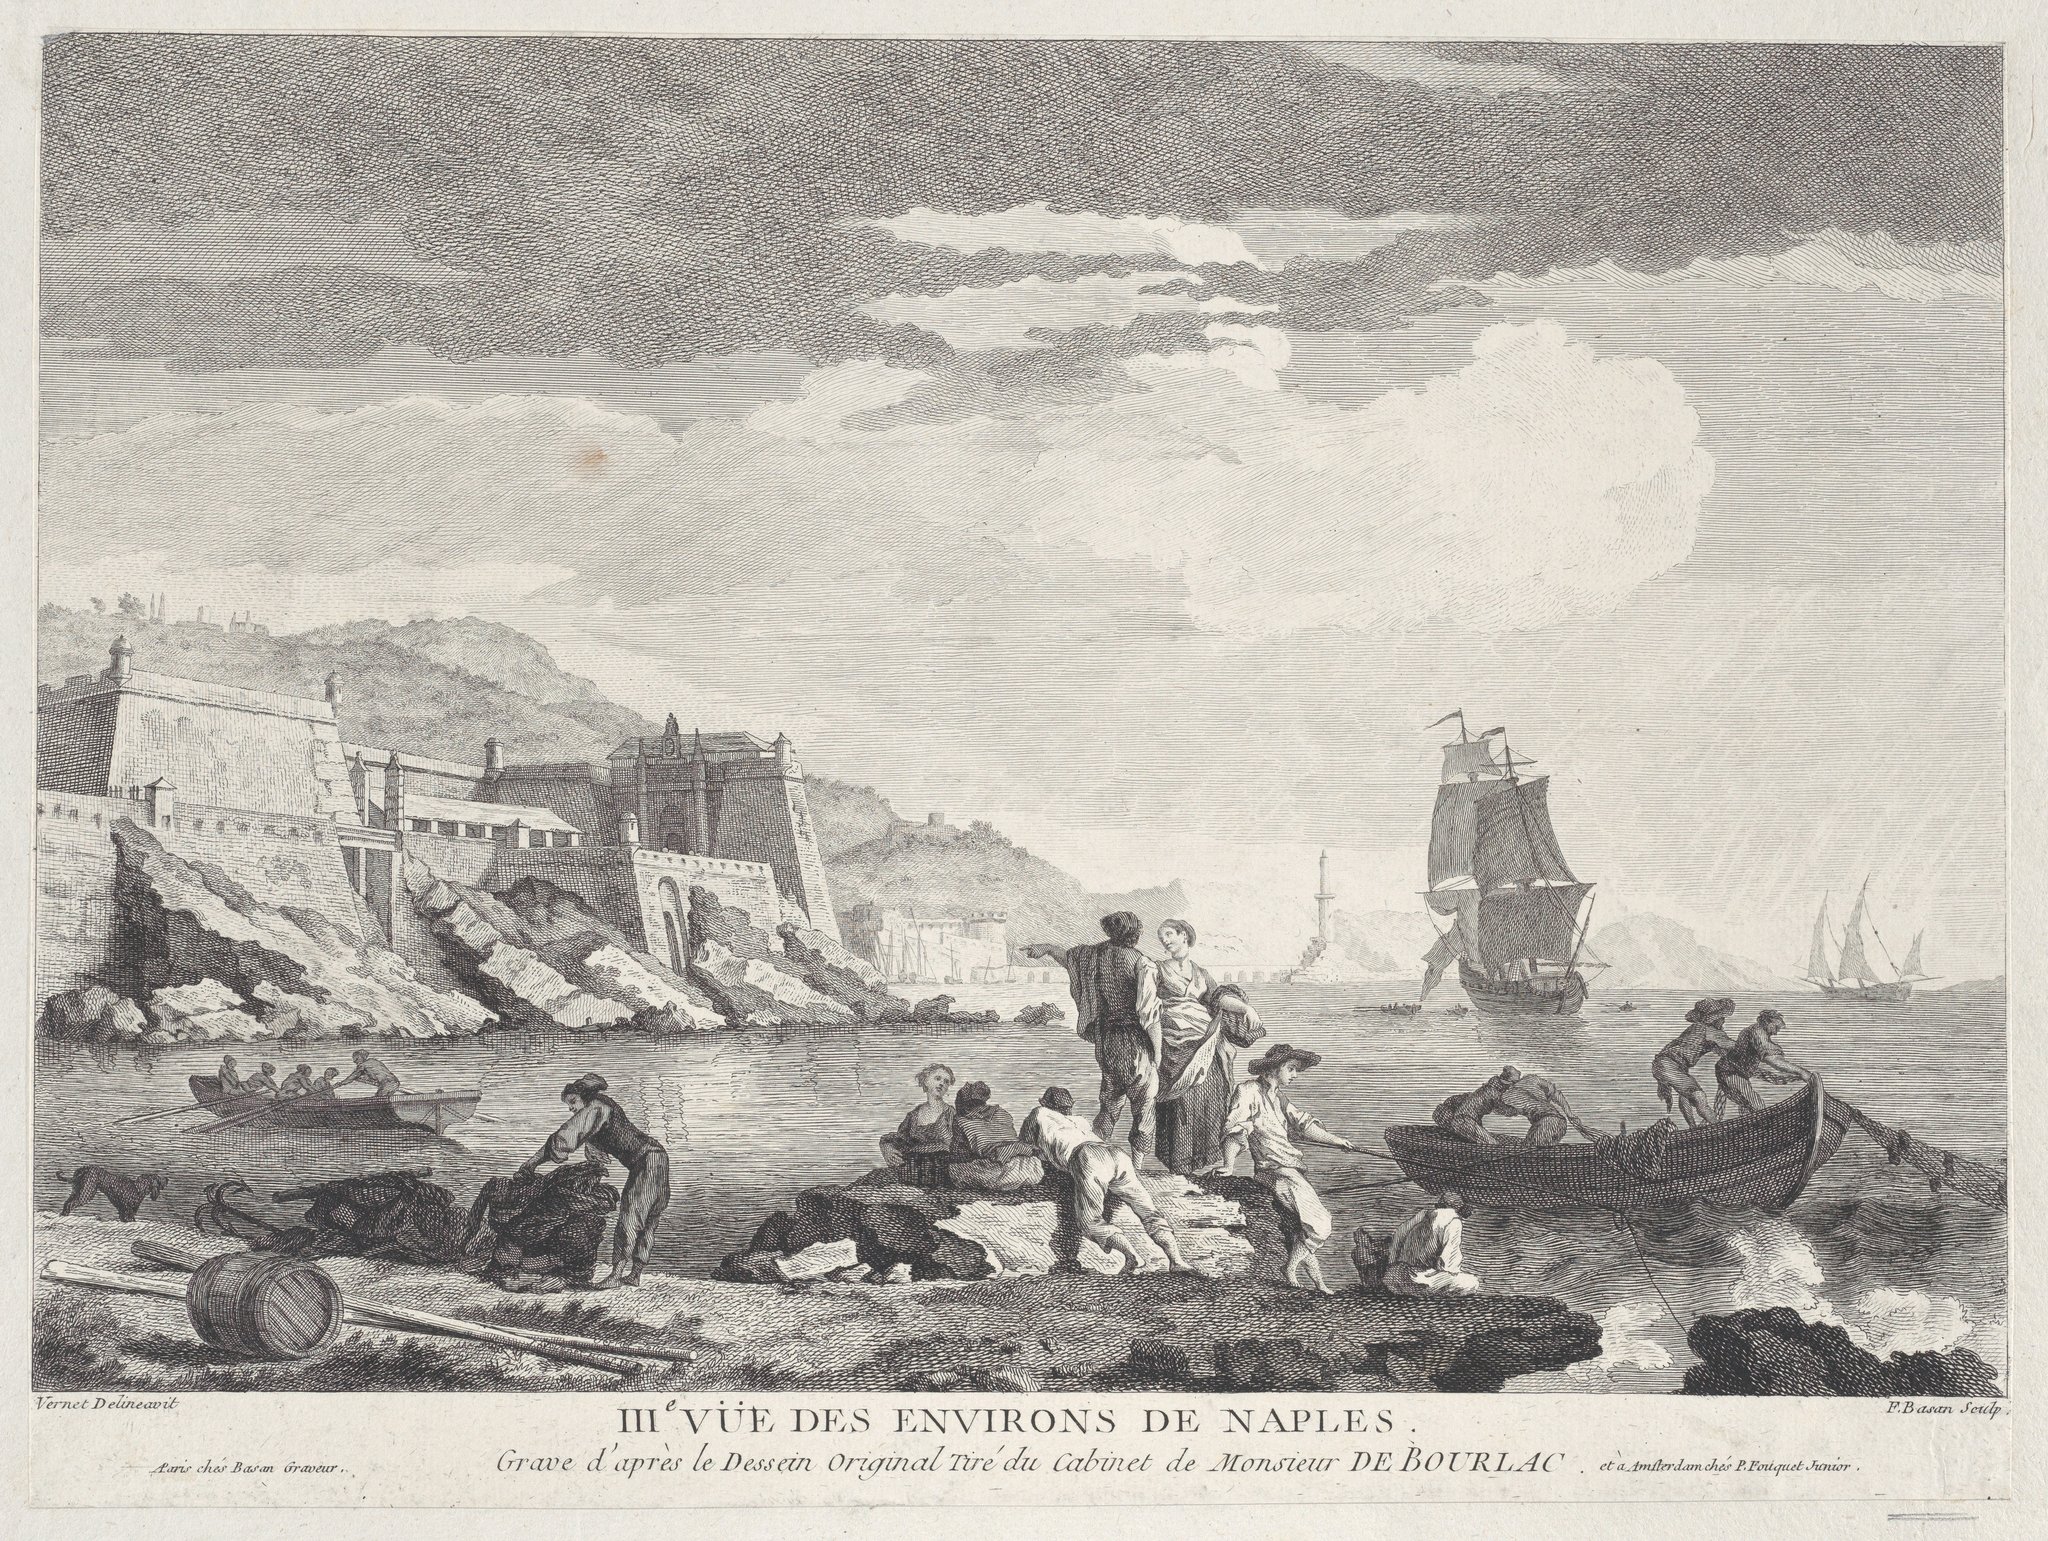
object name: print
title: Third View of the Surroundings of Naples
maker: joseph vernet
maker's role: artist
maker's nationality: french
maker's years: 1714-1789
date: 1760-1780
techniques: engraving